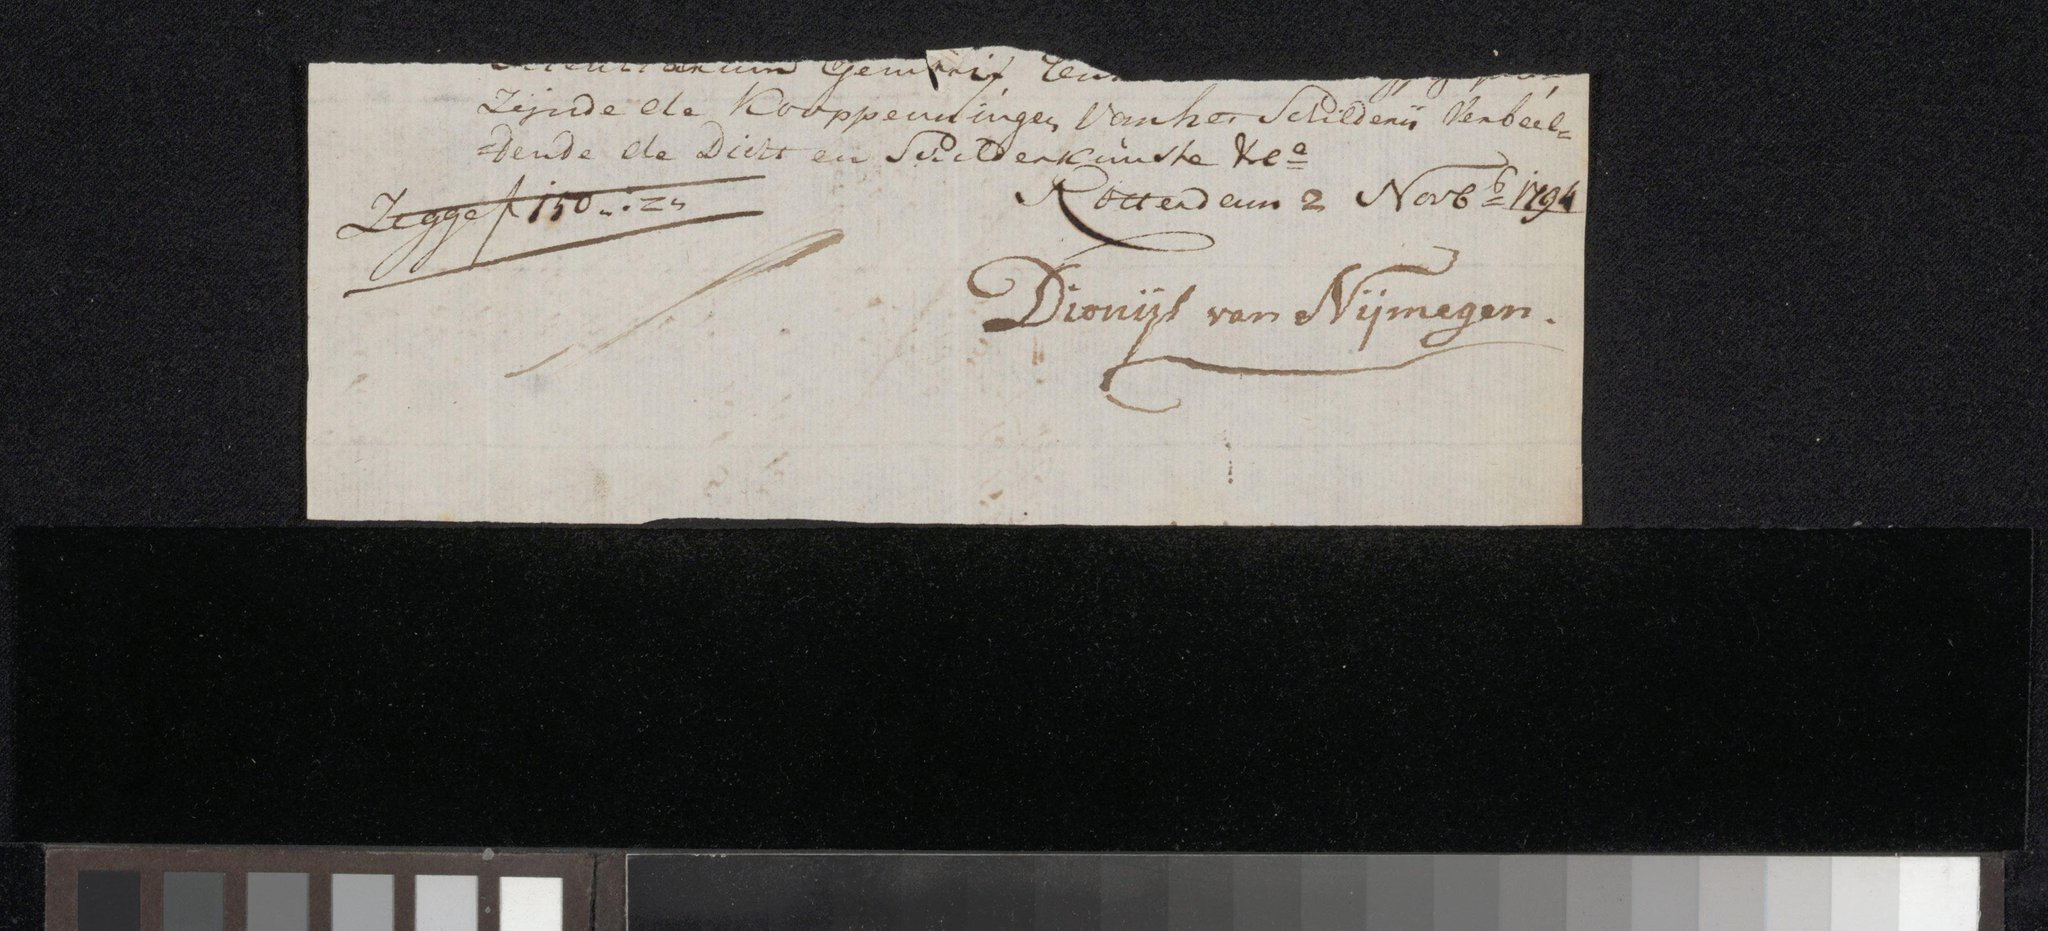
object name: ontvangstbewijs, kwitantie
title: Kwitantie voor anoniem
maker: dionys van nijmegen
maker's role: draughtsman, painter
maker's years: 1705-1798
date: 1794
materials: ink, paper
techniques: pen, writing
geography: rotterdam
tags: art trade, art shop, painting (including book-illumination, miniature-painting), money